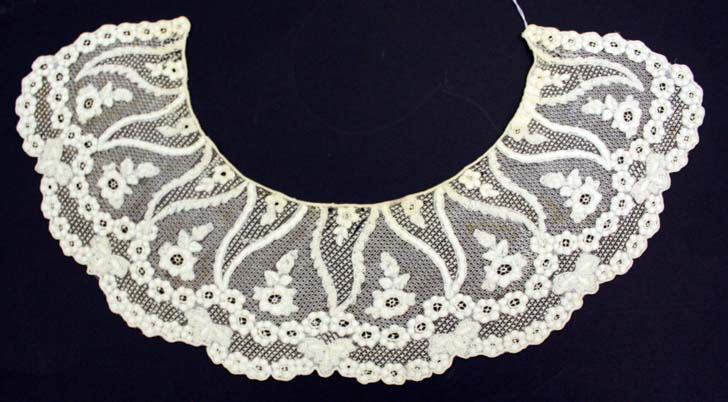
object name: collar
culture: american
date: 1842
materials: cotton